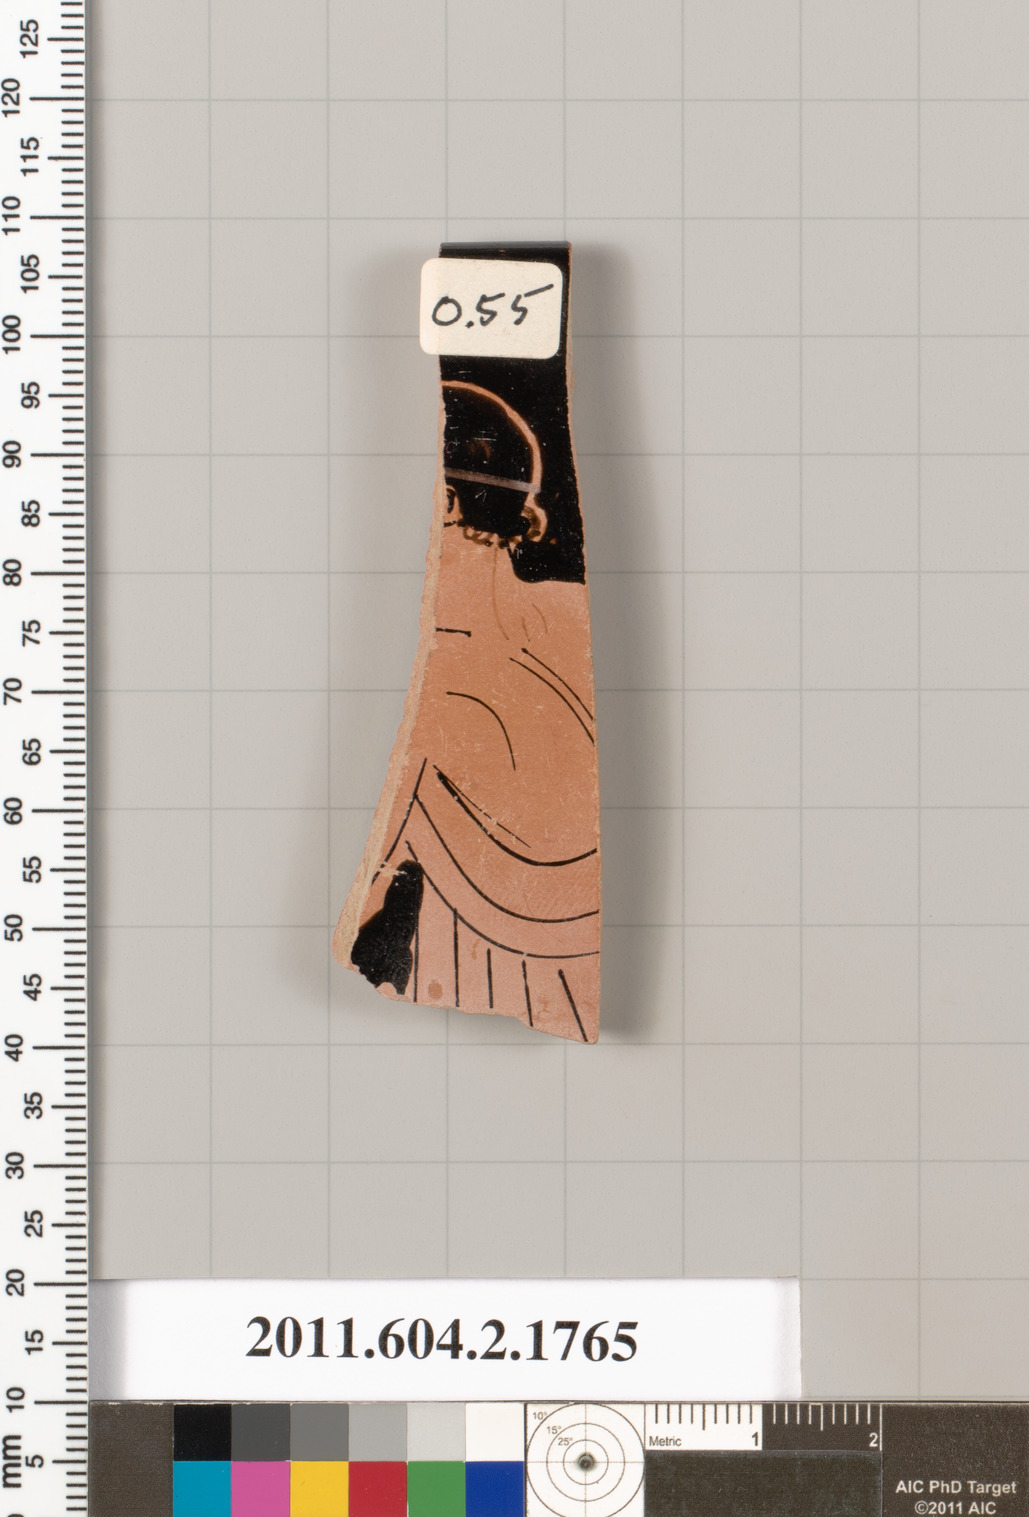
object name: skyphos fragment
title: Terracotta rim fragment of a skyphos (deep drinking cup)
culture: greek, attic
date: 470-450 BCE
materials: terracotta